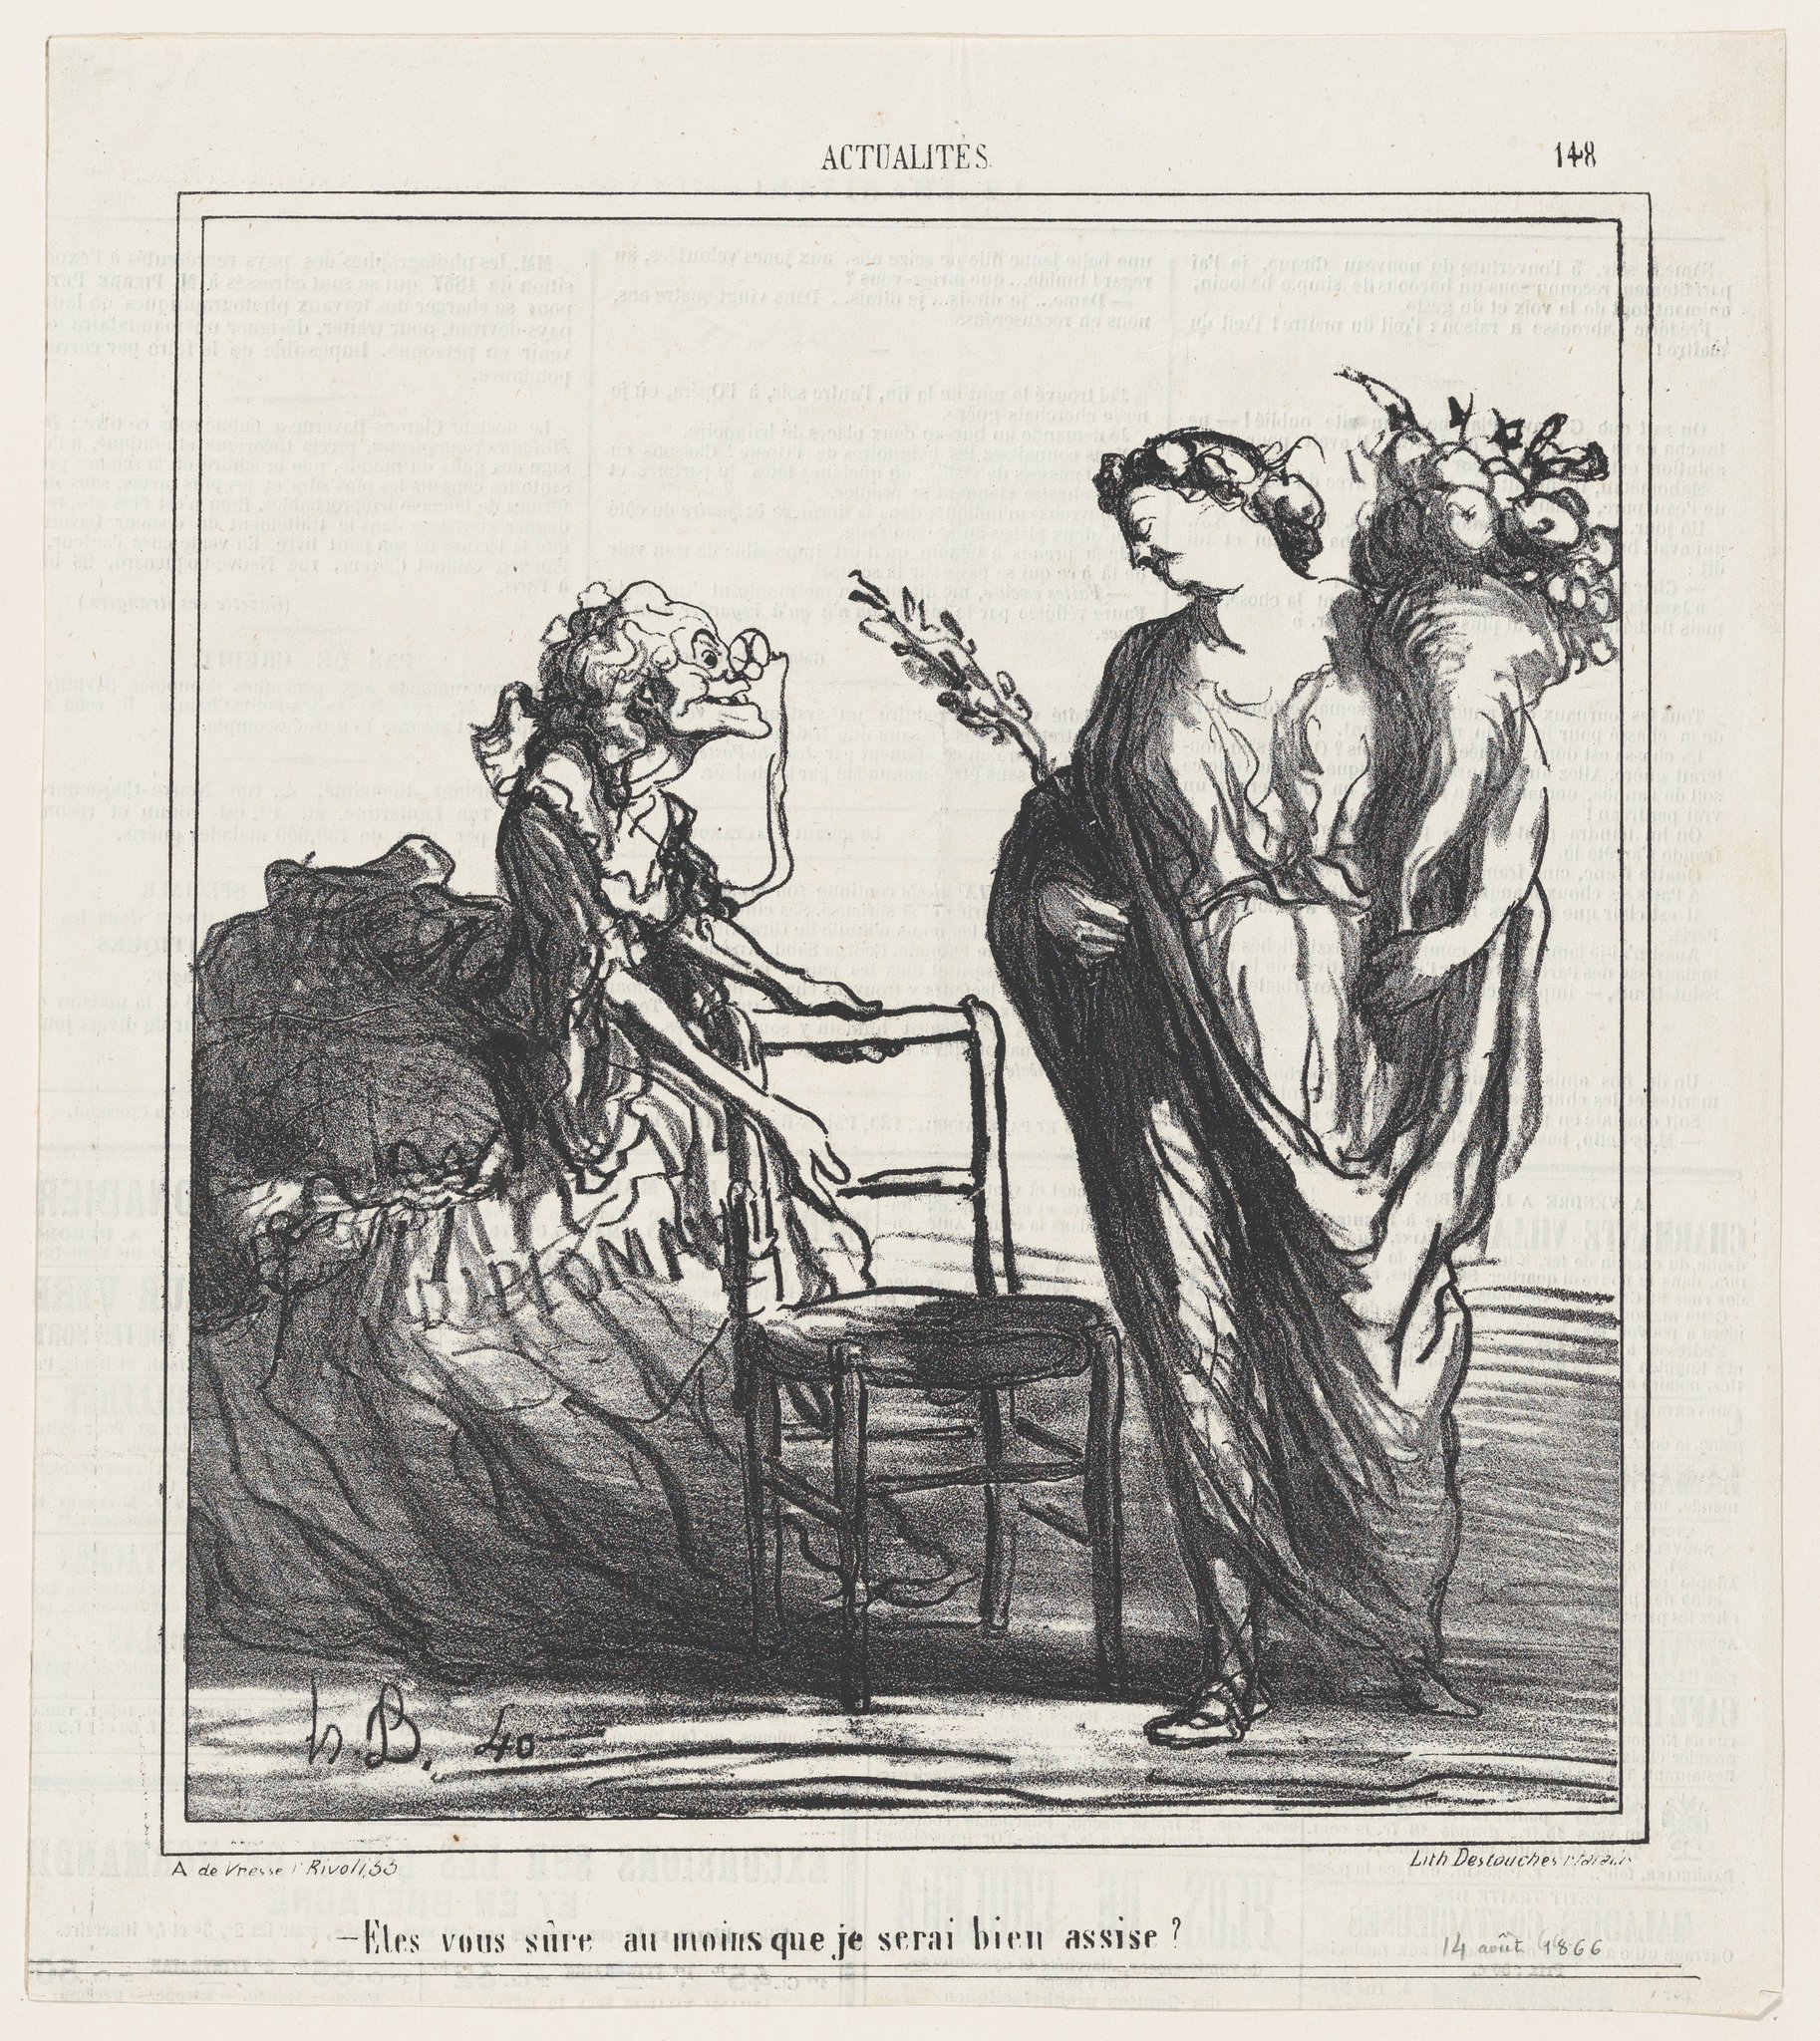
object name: print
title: Are you sure at least that I will be comfortable?, from 'News of the day,' published in Le Charivari, August 14, 1866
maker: honoré daumier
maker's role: artist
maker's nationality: french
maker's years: 1808-1879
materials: paper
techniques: lithograph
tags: satire,women